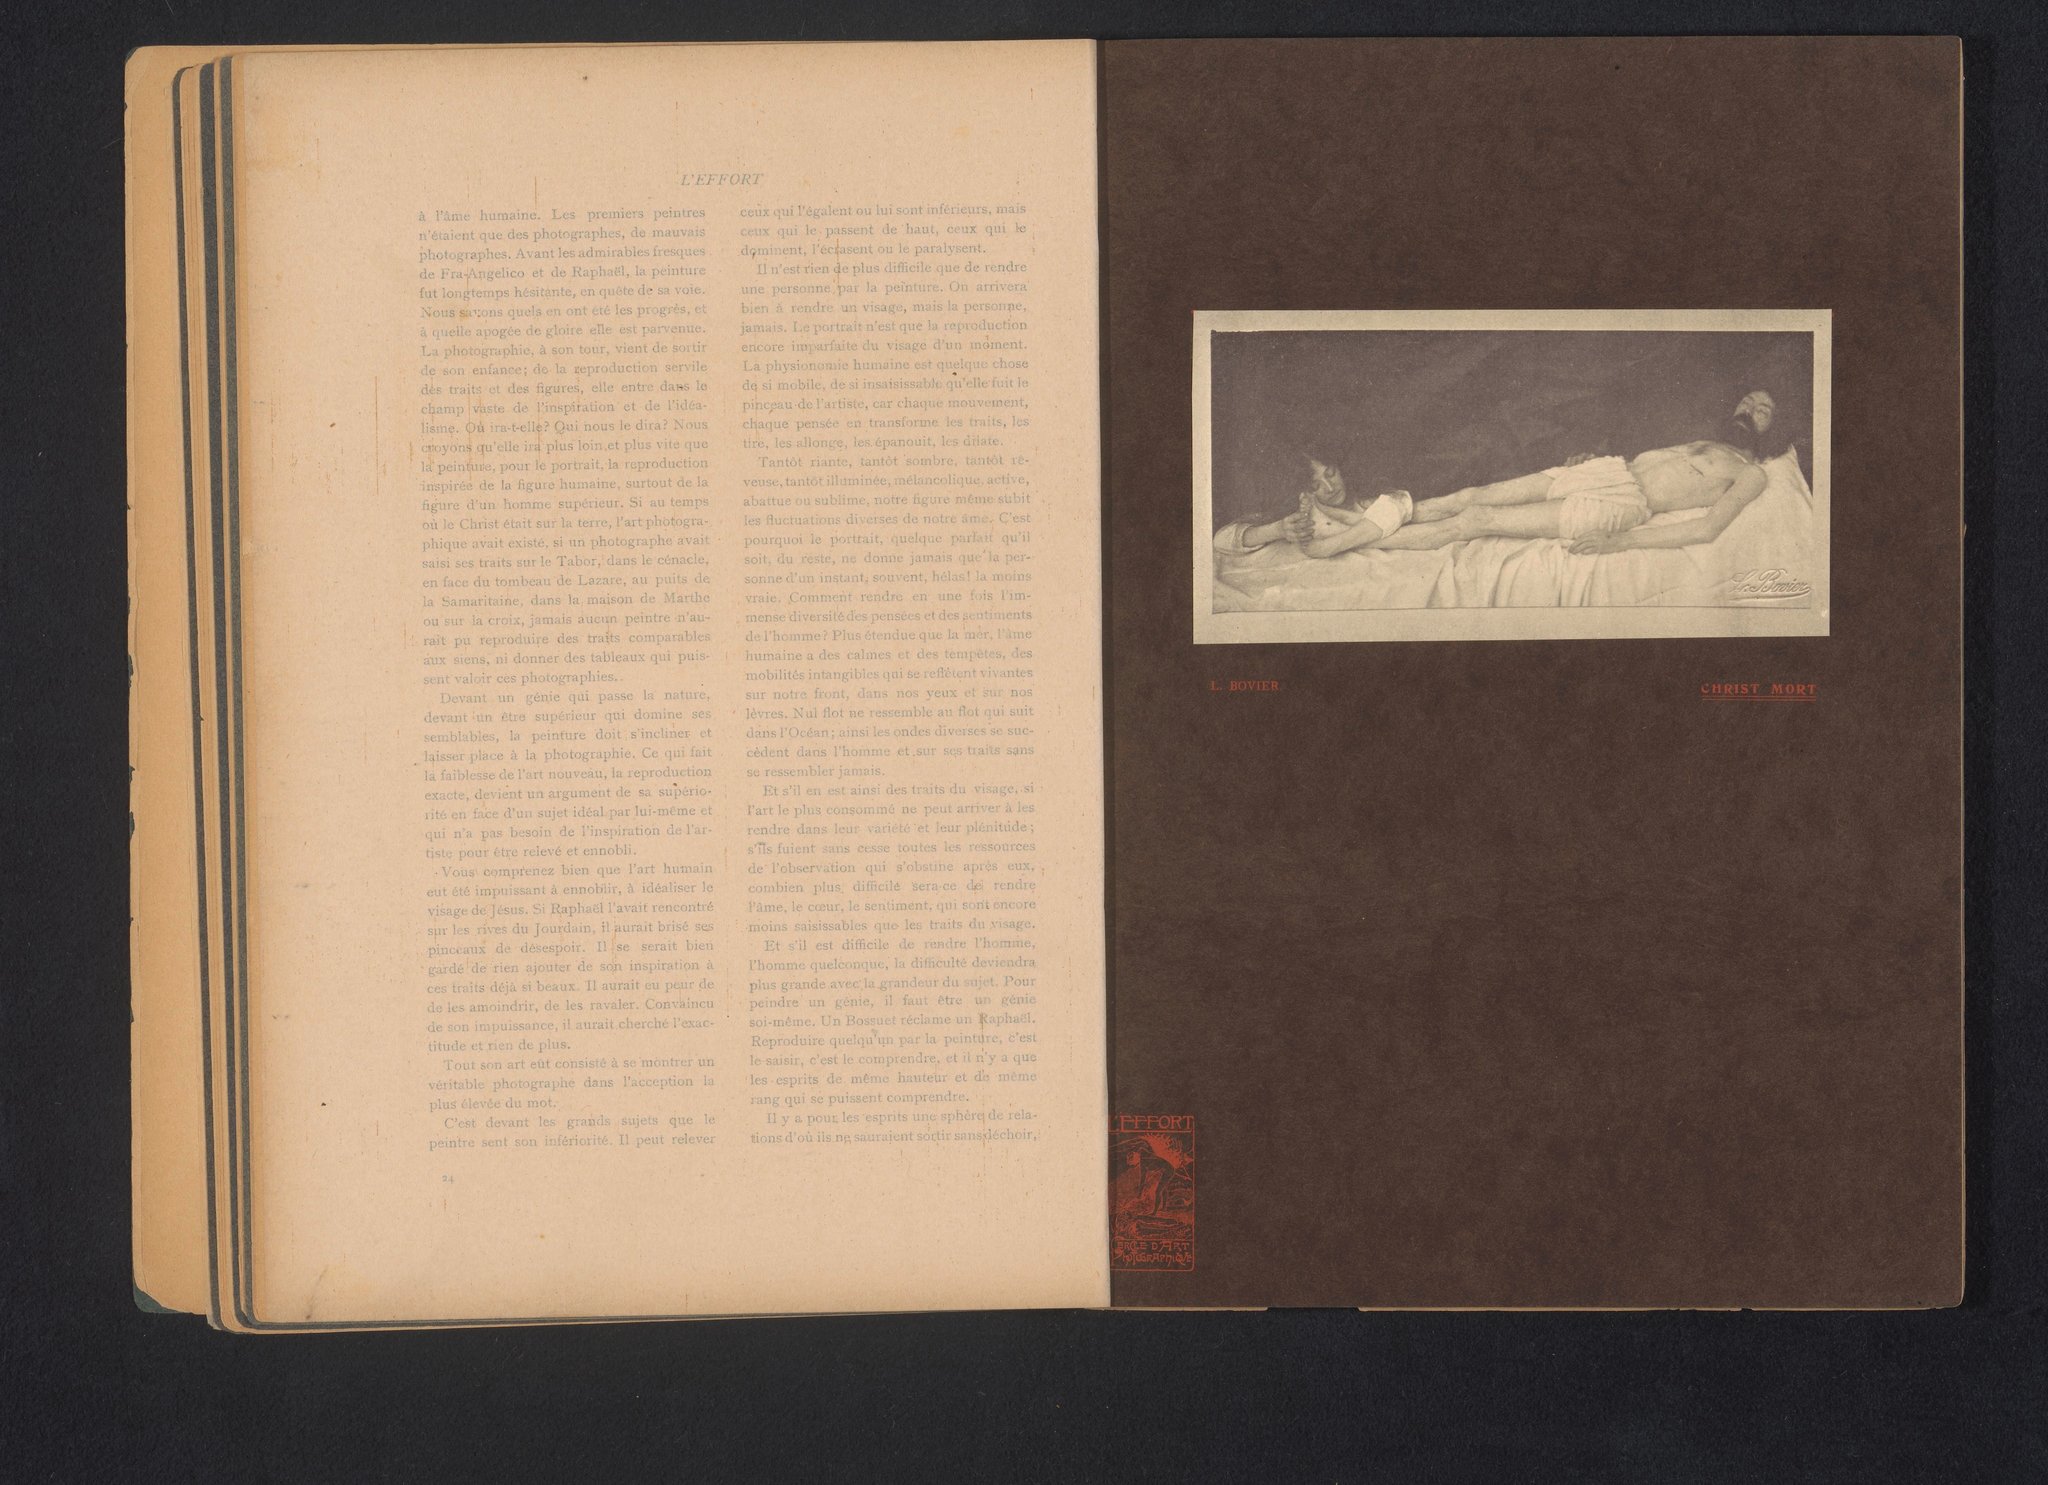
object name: page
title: Christus ligt dood opgebaard, met een vrouw aan zijn voeten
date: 1896-1901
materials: paper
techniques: autotype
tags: the mourning over the dead christ, actor (on the stage)